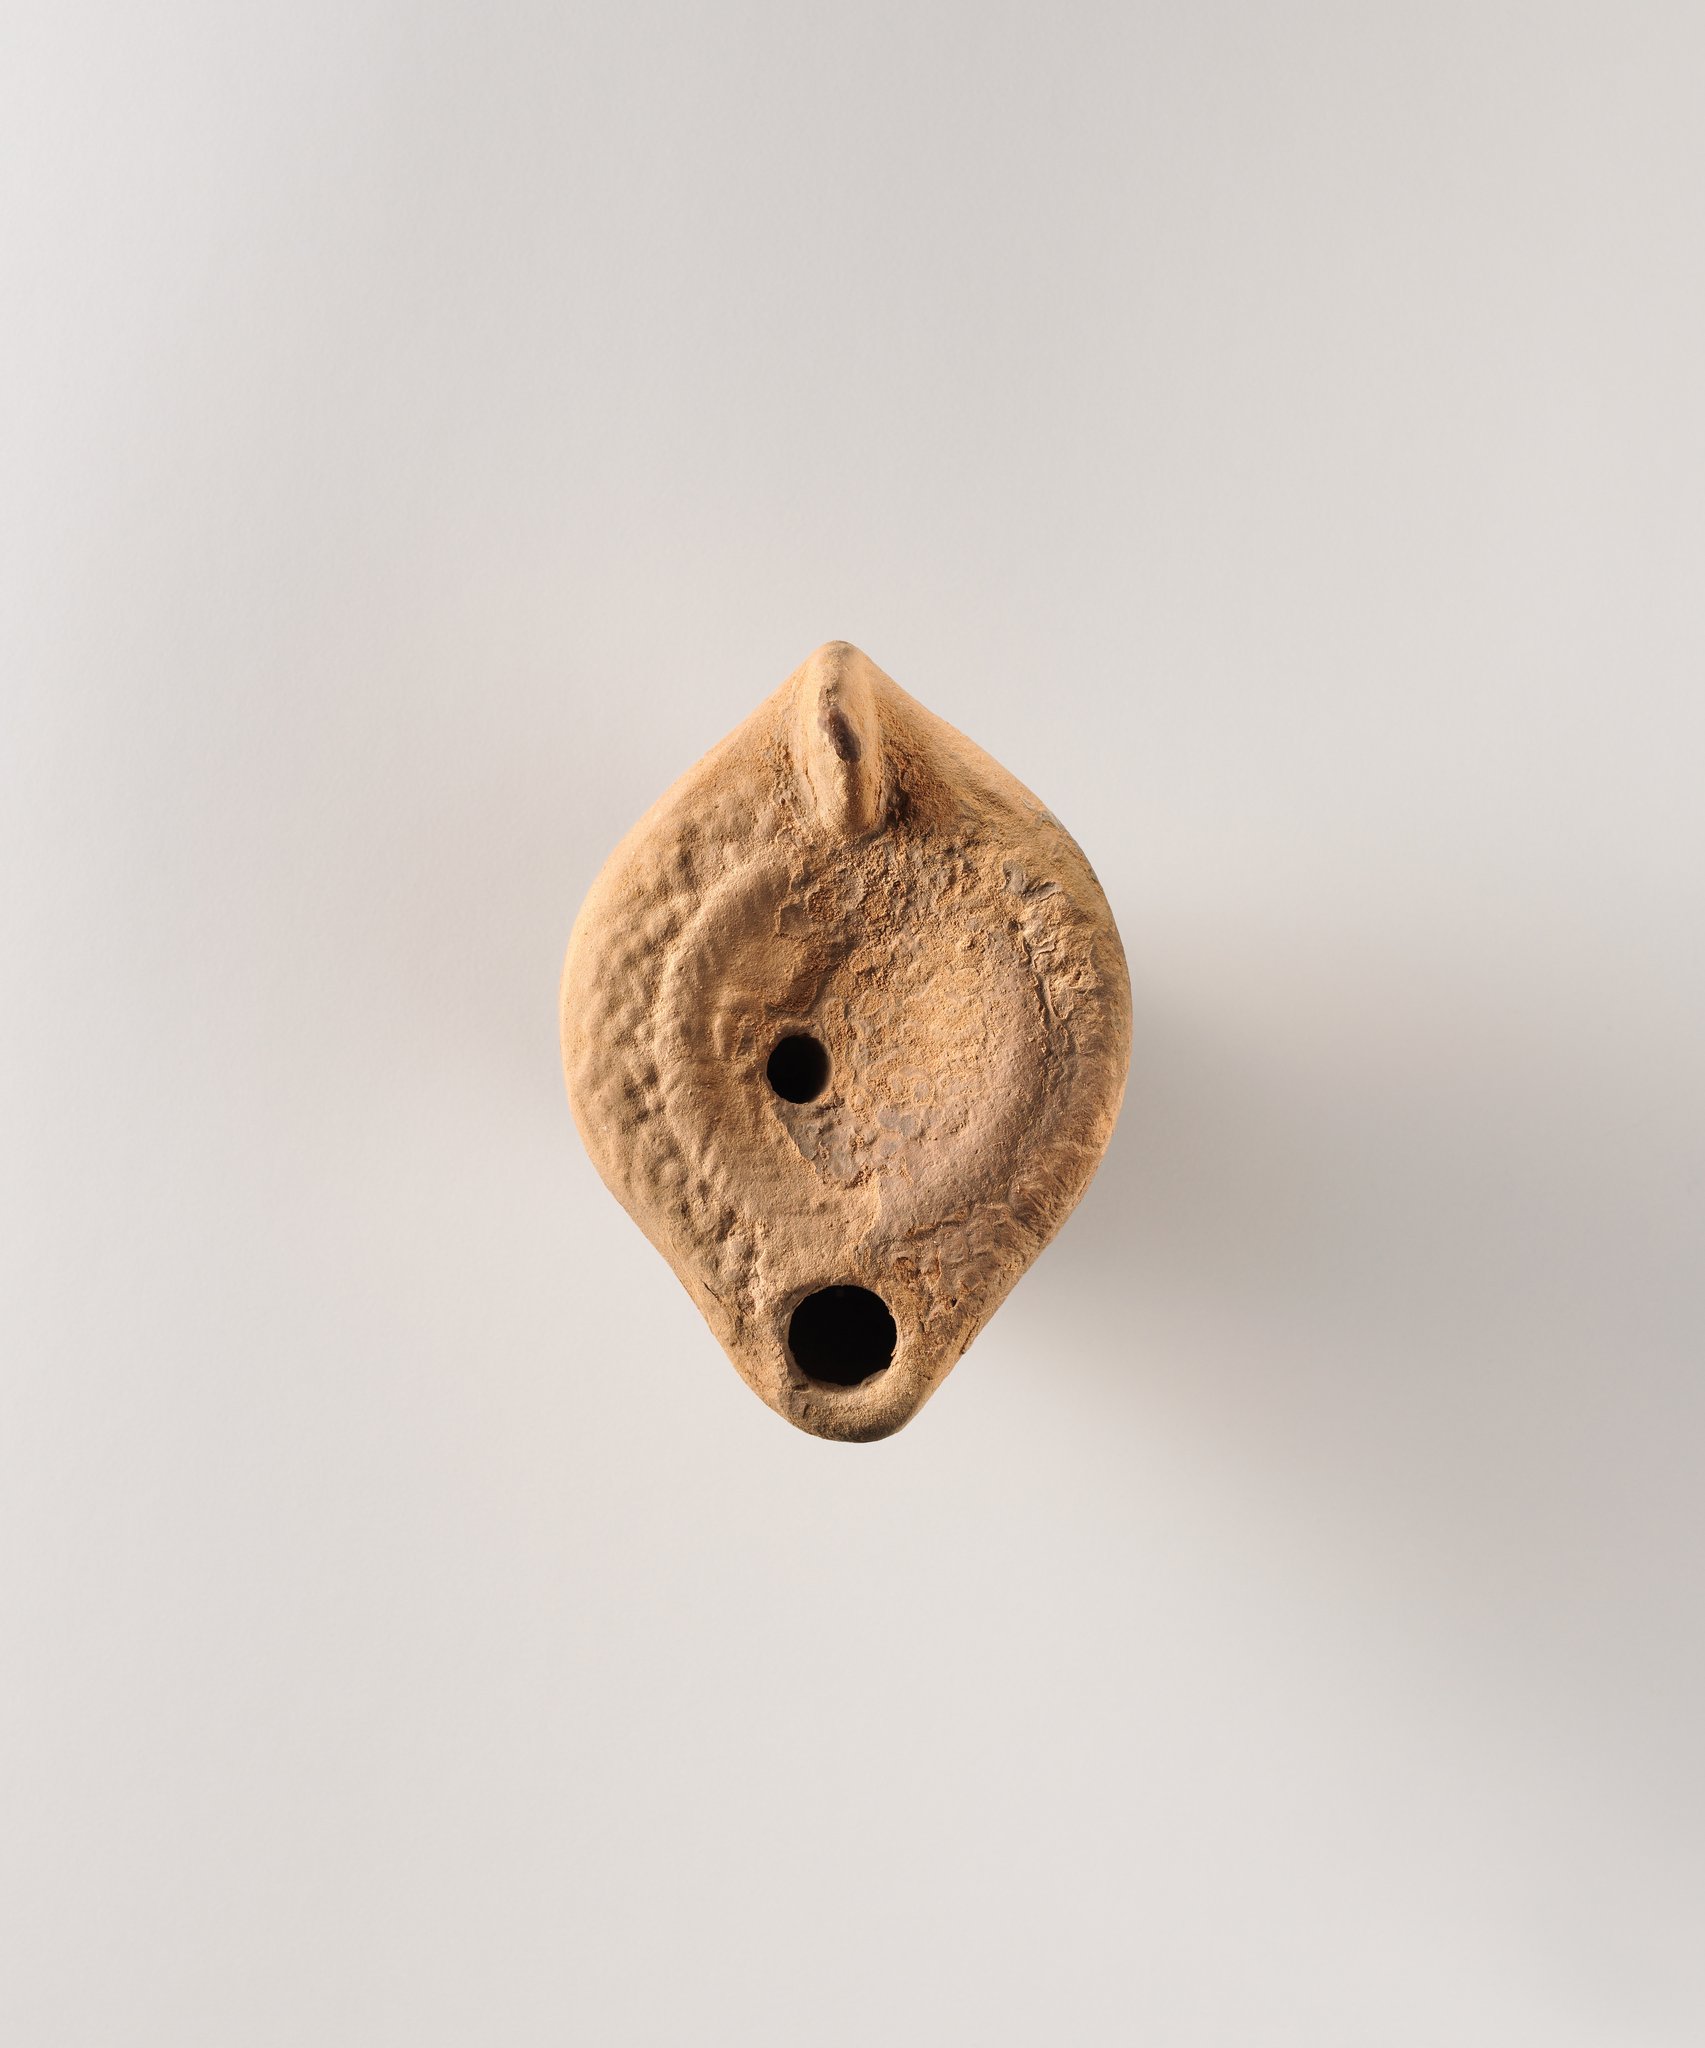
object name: lamp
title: Terracotta oil lamp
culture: roman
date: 201-300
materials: terracotta